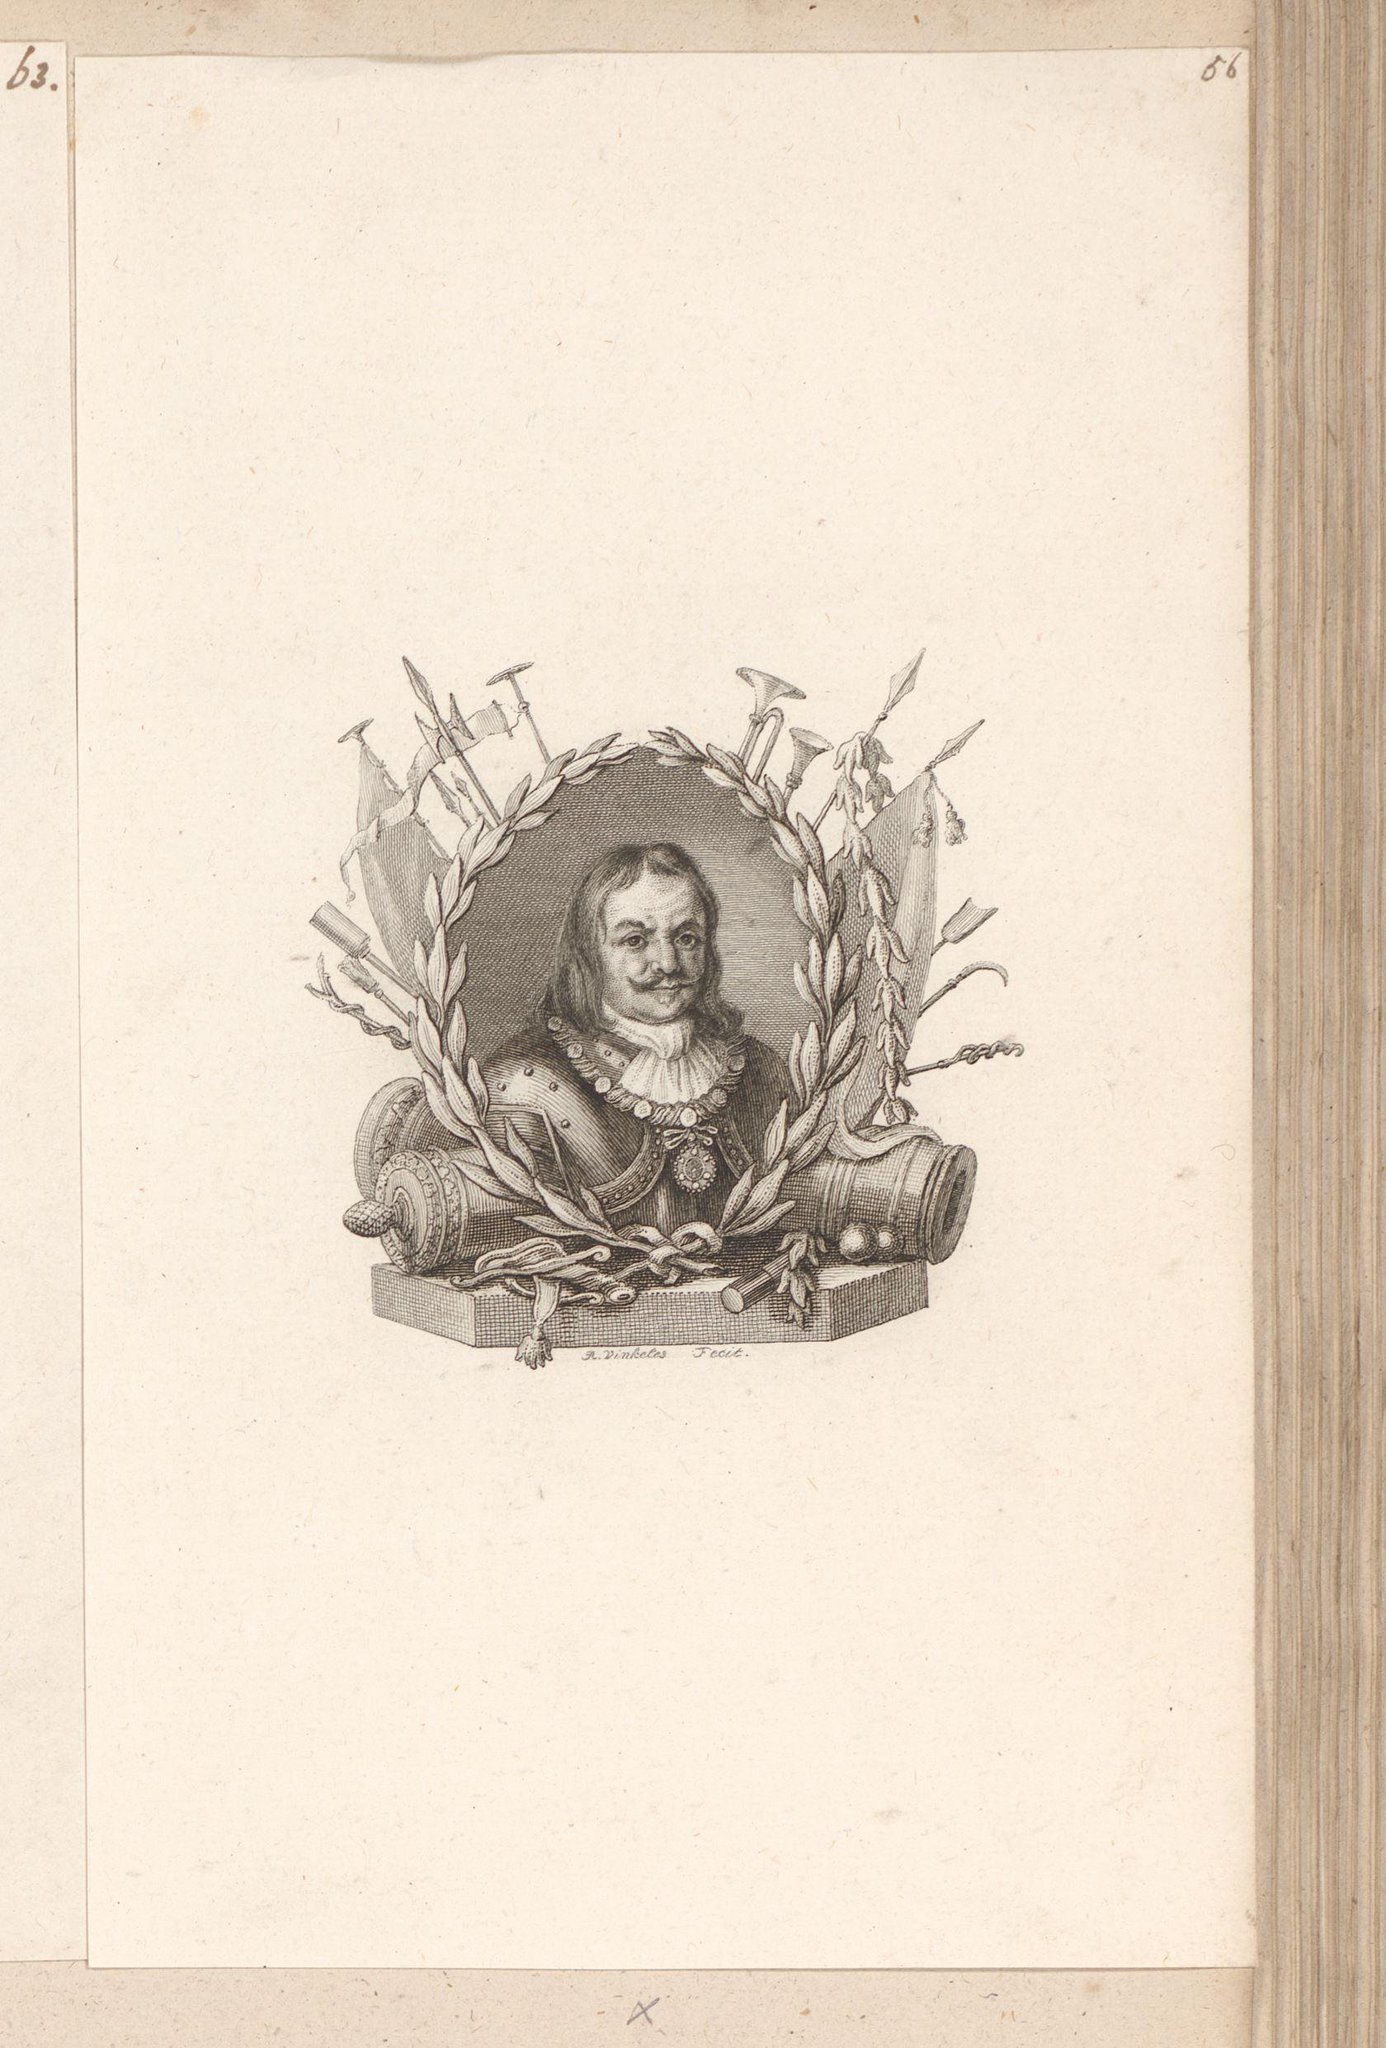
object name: print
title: Portret van Michiel Adriaenszoon de Ruyter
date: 1812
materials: paper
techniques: engraving, etching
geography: amsterdam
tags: flushing, michiel adriaenszoon de ruyter, title-page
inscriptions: inscription: ‘56’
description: Proefdruk van de titelpagina gebruikt voor: Loosjes, Adriaan Pietersz. De laatste zeetogt van den admiraal De Ruiter. Haarlem: Adriaan Loosjes, 1812